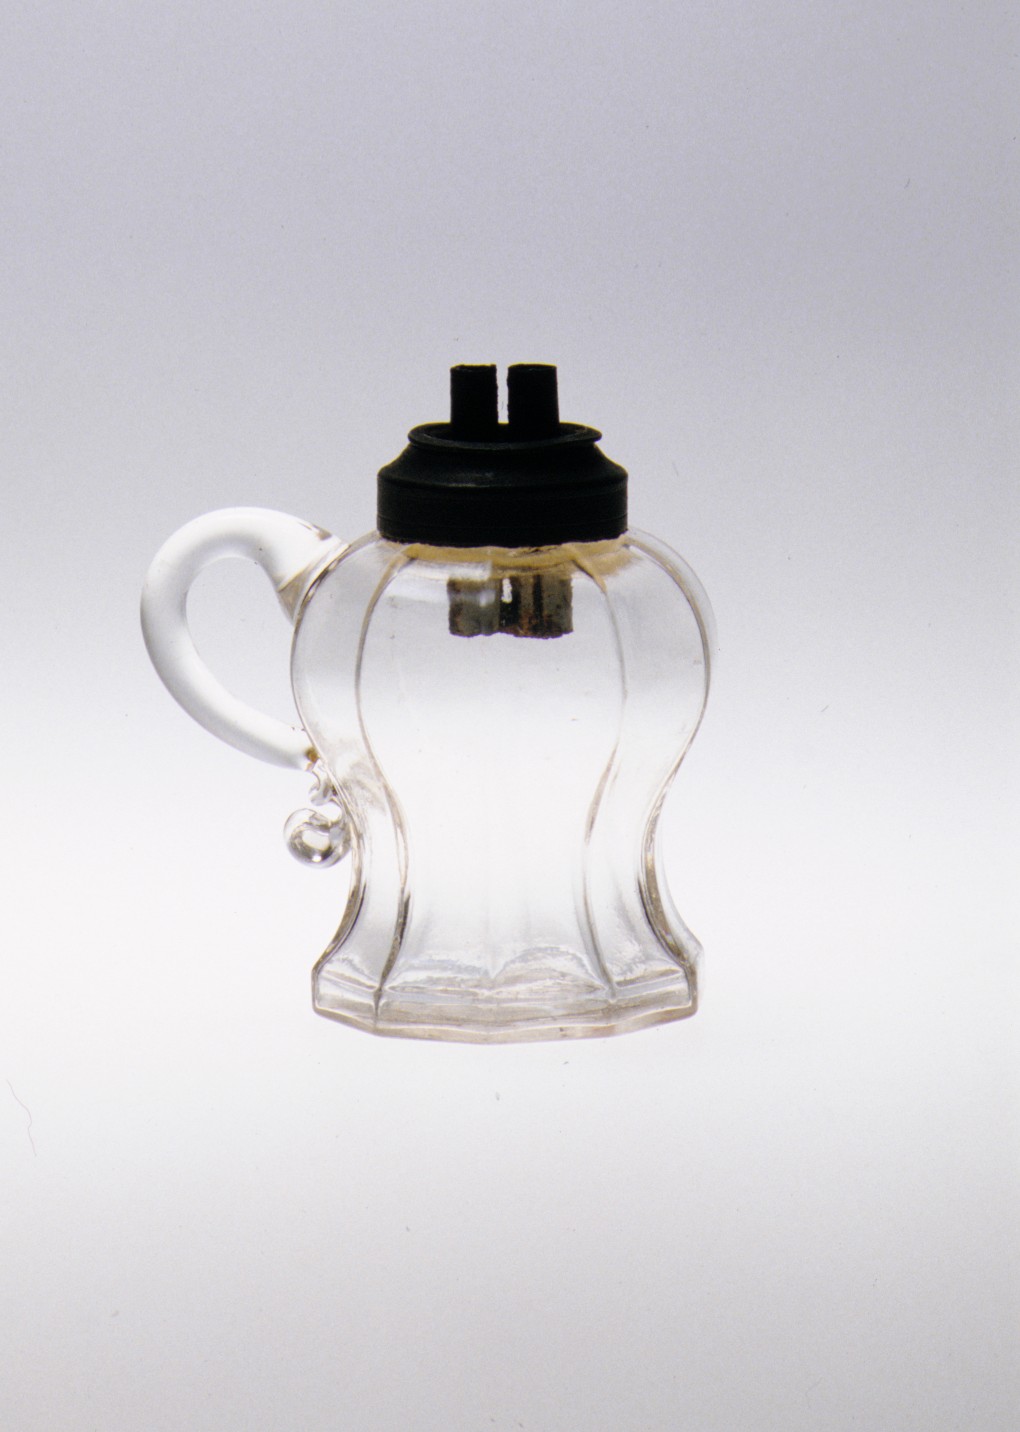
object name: whale oil lamp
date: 1860-1880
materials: glass, lead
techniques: glassblowing